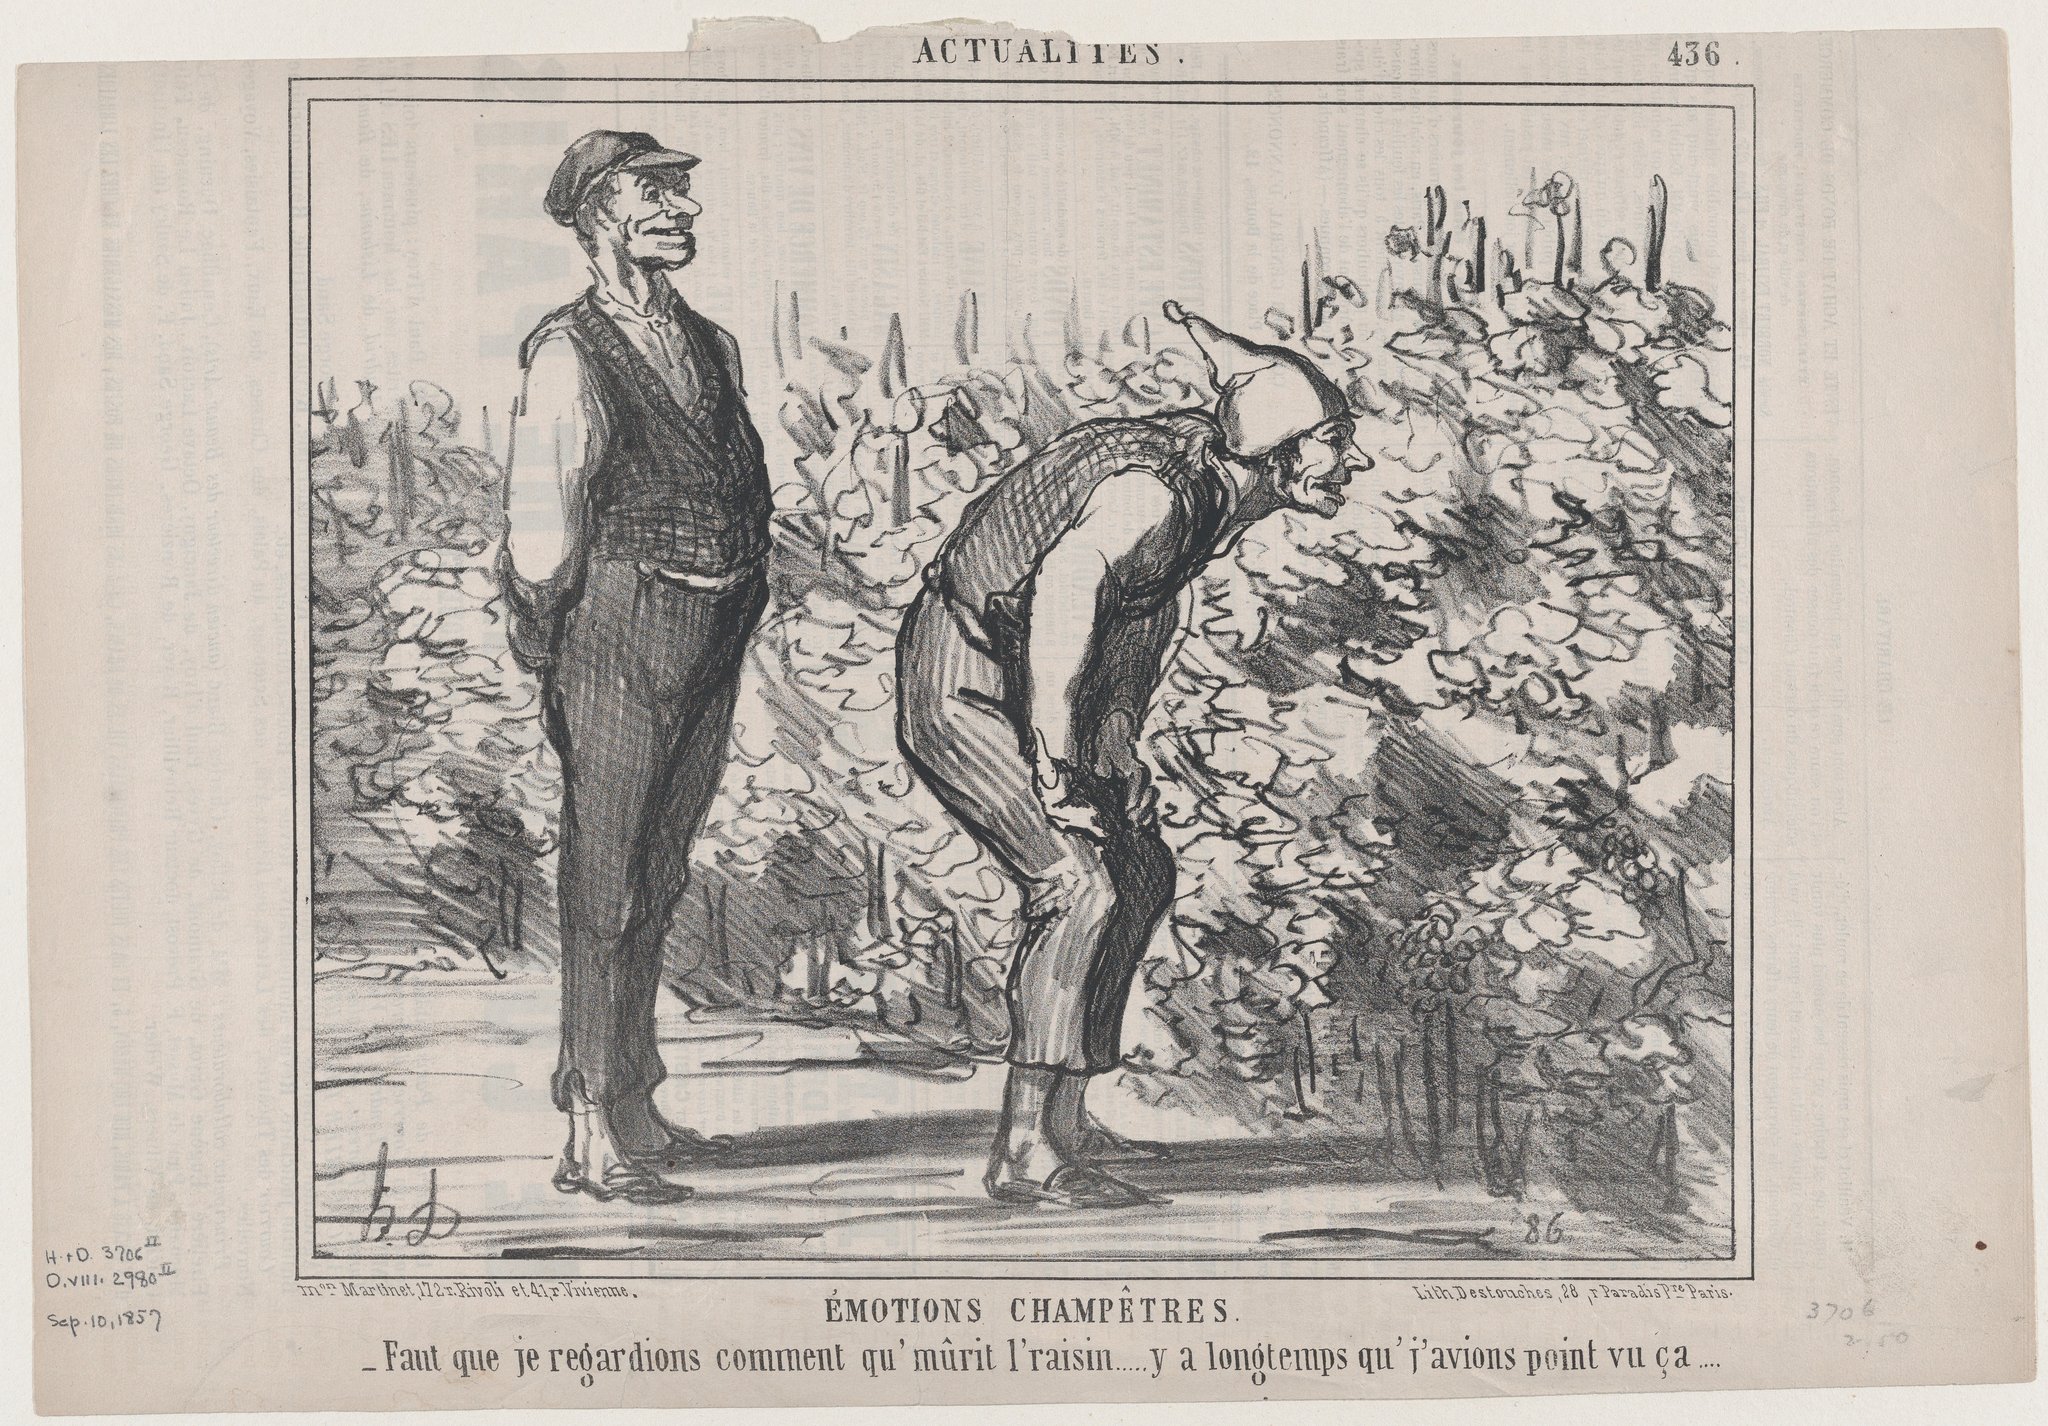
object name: print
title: Émotions Champêtres, from "Actualités"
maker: honoré daumier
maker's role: artist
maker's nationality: french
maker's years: 1808-1879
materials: paper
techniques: lithograph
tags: men